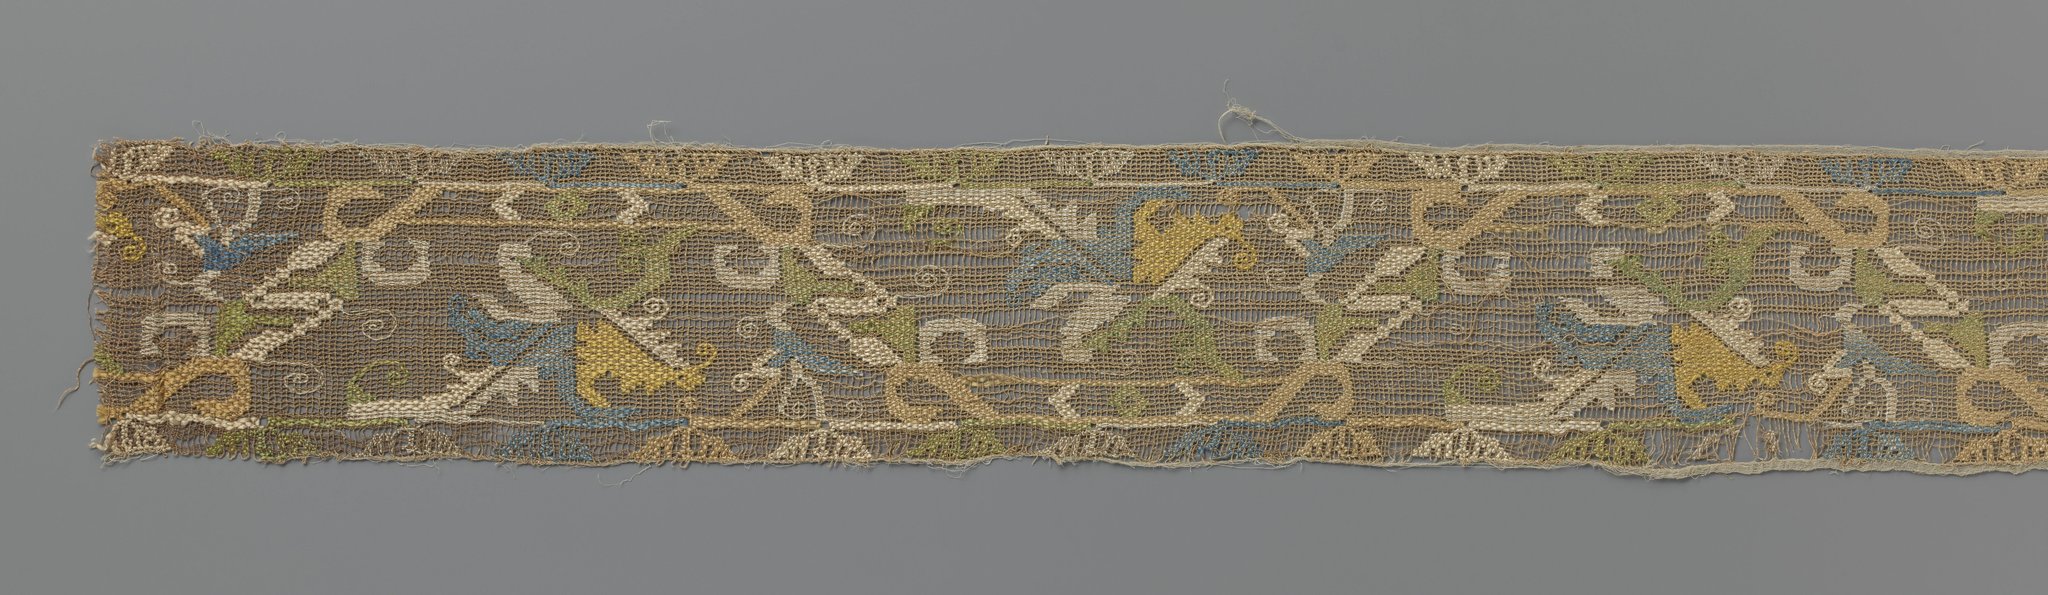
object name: strip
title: Strook gekleurd kantborduurwerk met wingerdblad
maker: Anonymous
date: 1585-1599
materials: textile, linen, silk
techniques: embroidery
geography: italy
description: Strook gekleurd kantborduurwerk: Burato-kant. Op een slingerdraadweefsel van lichtbruine zijde en linnen is met zijdedraad in de kleuren blauw, groen, geel en crème een randpatroon in doorstoptechniek aangebracht. Het patroon bestaat uit een hoekige lopende rank, met daaraan een schuingericht wingerdblad. Omlijsting door een rij van driehoekige bladeren (?) aan een stengel.